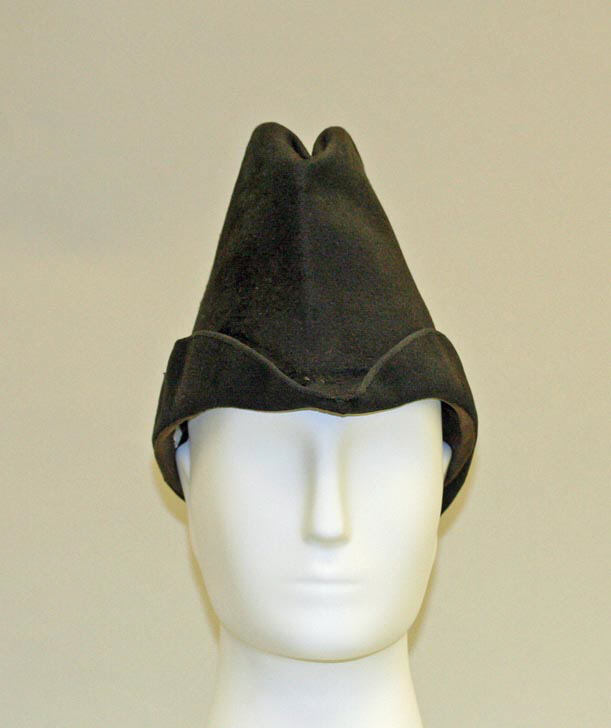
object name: hat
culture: french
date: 1828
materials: wool